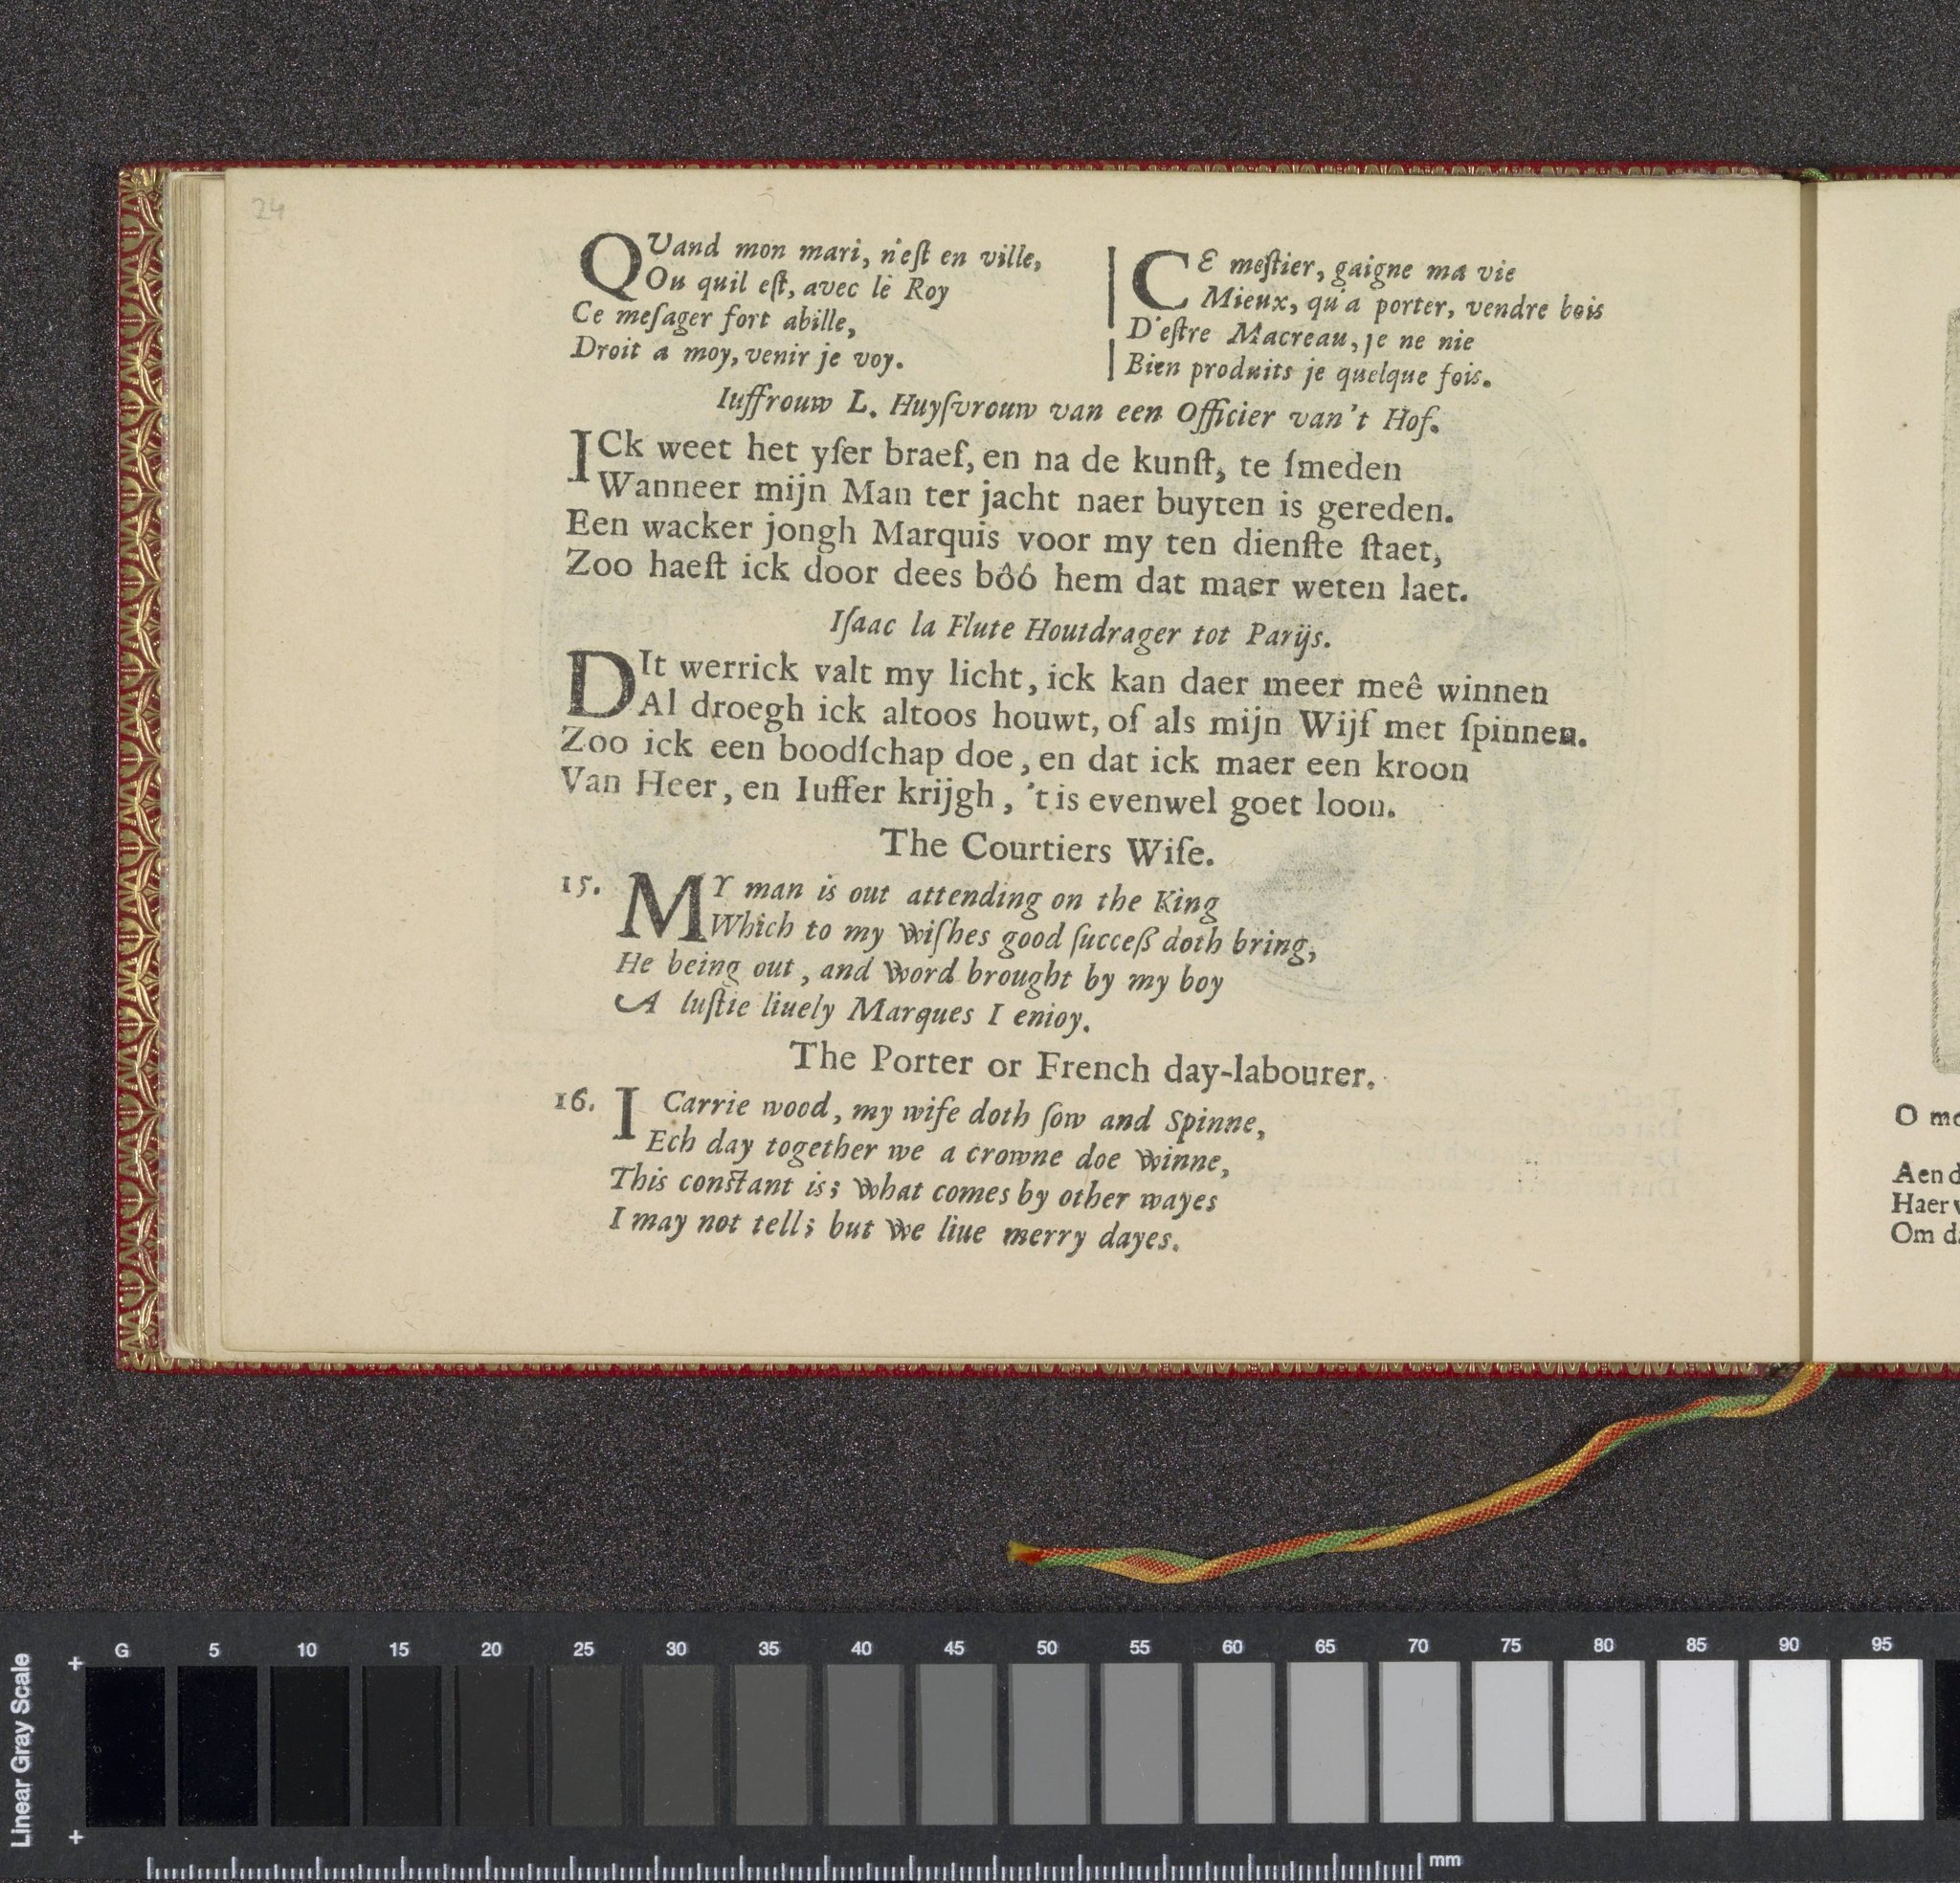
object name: album leaf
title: Kwatrijnen bij voorstellingen van een officiersvrouw en een houtdrager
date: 1641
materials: paper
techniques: letterpress printing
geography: amsterdam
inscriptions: date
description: Drie keer twee kwatrijnen in het Frans, Nederlands en Engels bij voorstellingen de huisvrouw van een officier aan het hof en een houtdrager. Het blad maakt deel uit van een album.